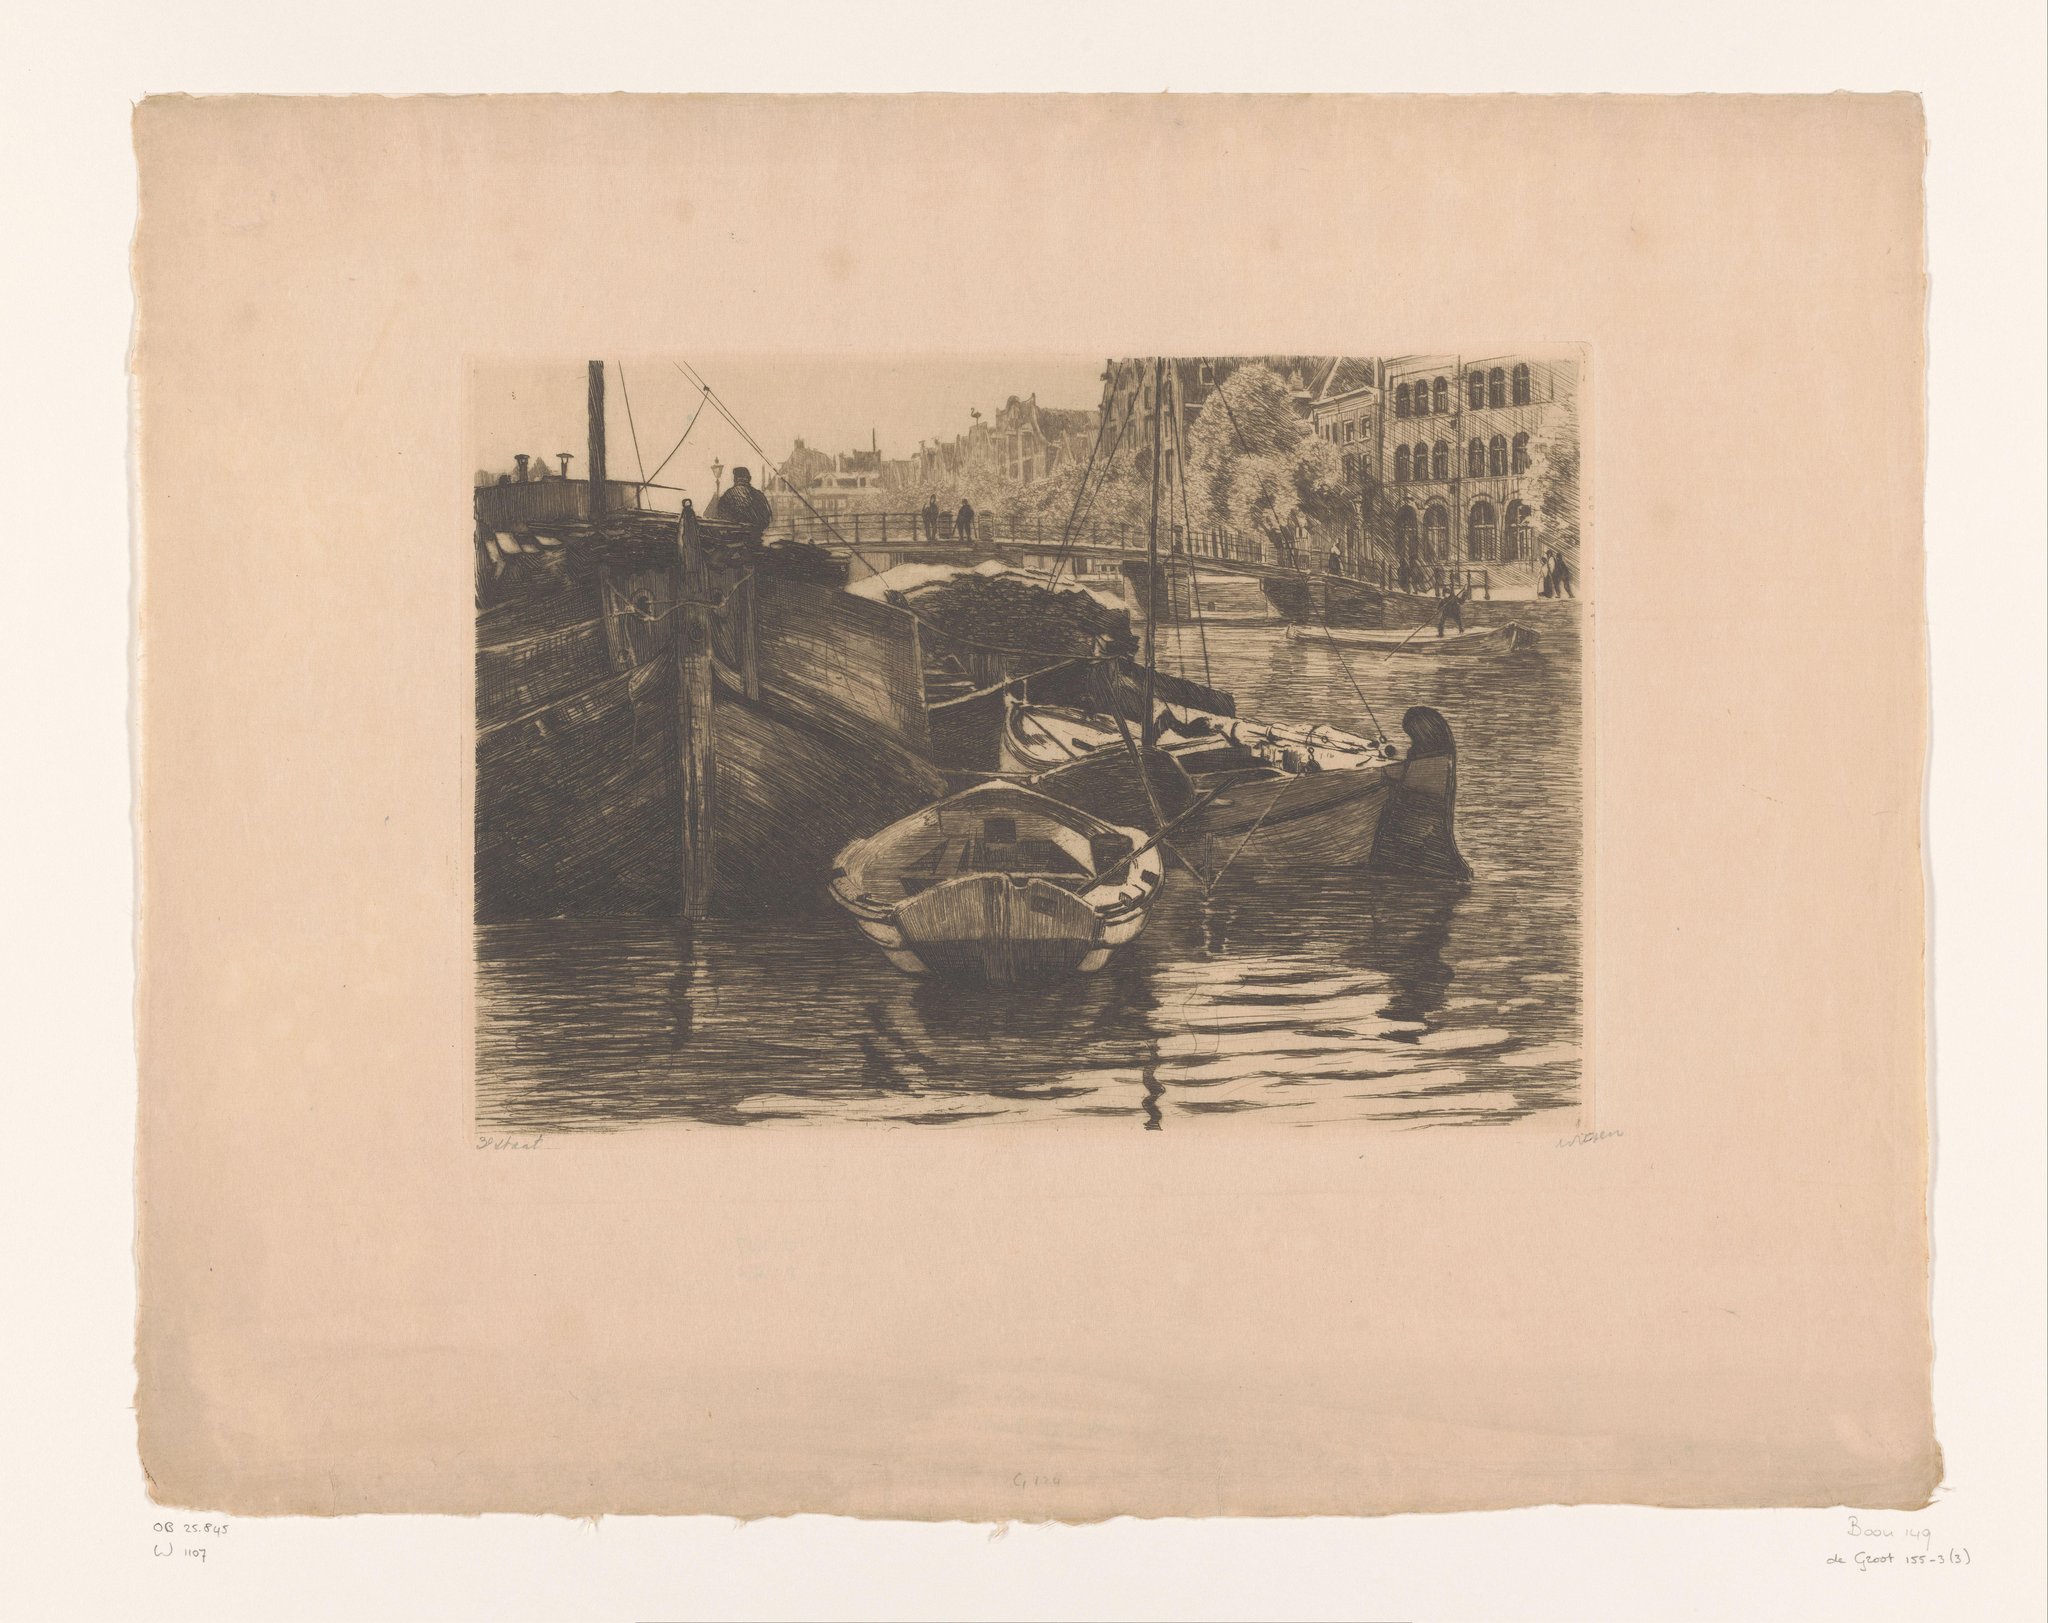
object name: print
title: Turfschepen bij de Keizersbrug in Amsterdam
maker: willem witsen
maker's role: draughtsman, painter, print maker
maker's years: 1860-1923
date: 1911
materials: paper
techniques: etching, intaglio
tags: urban housing, sailing-ship, sailing-boat, bridge in city across river, canal, etc.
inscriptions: annotation: ‘3e staat’